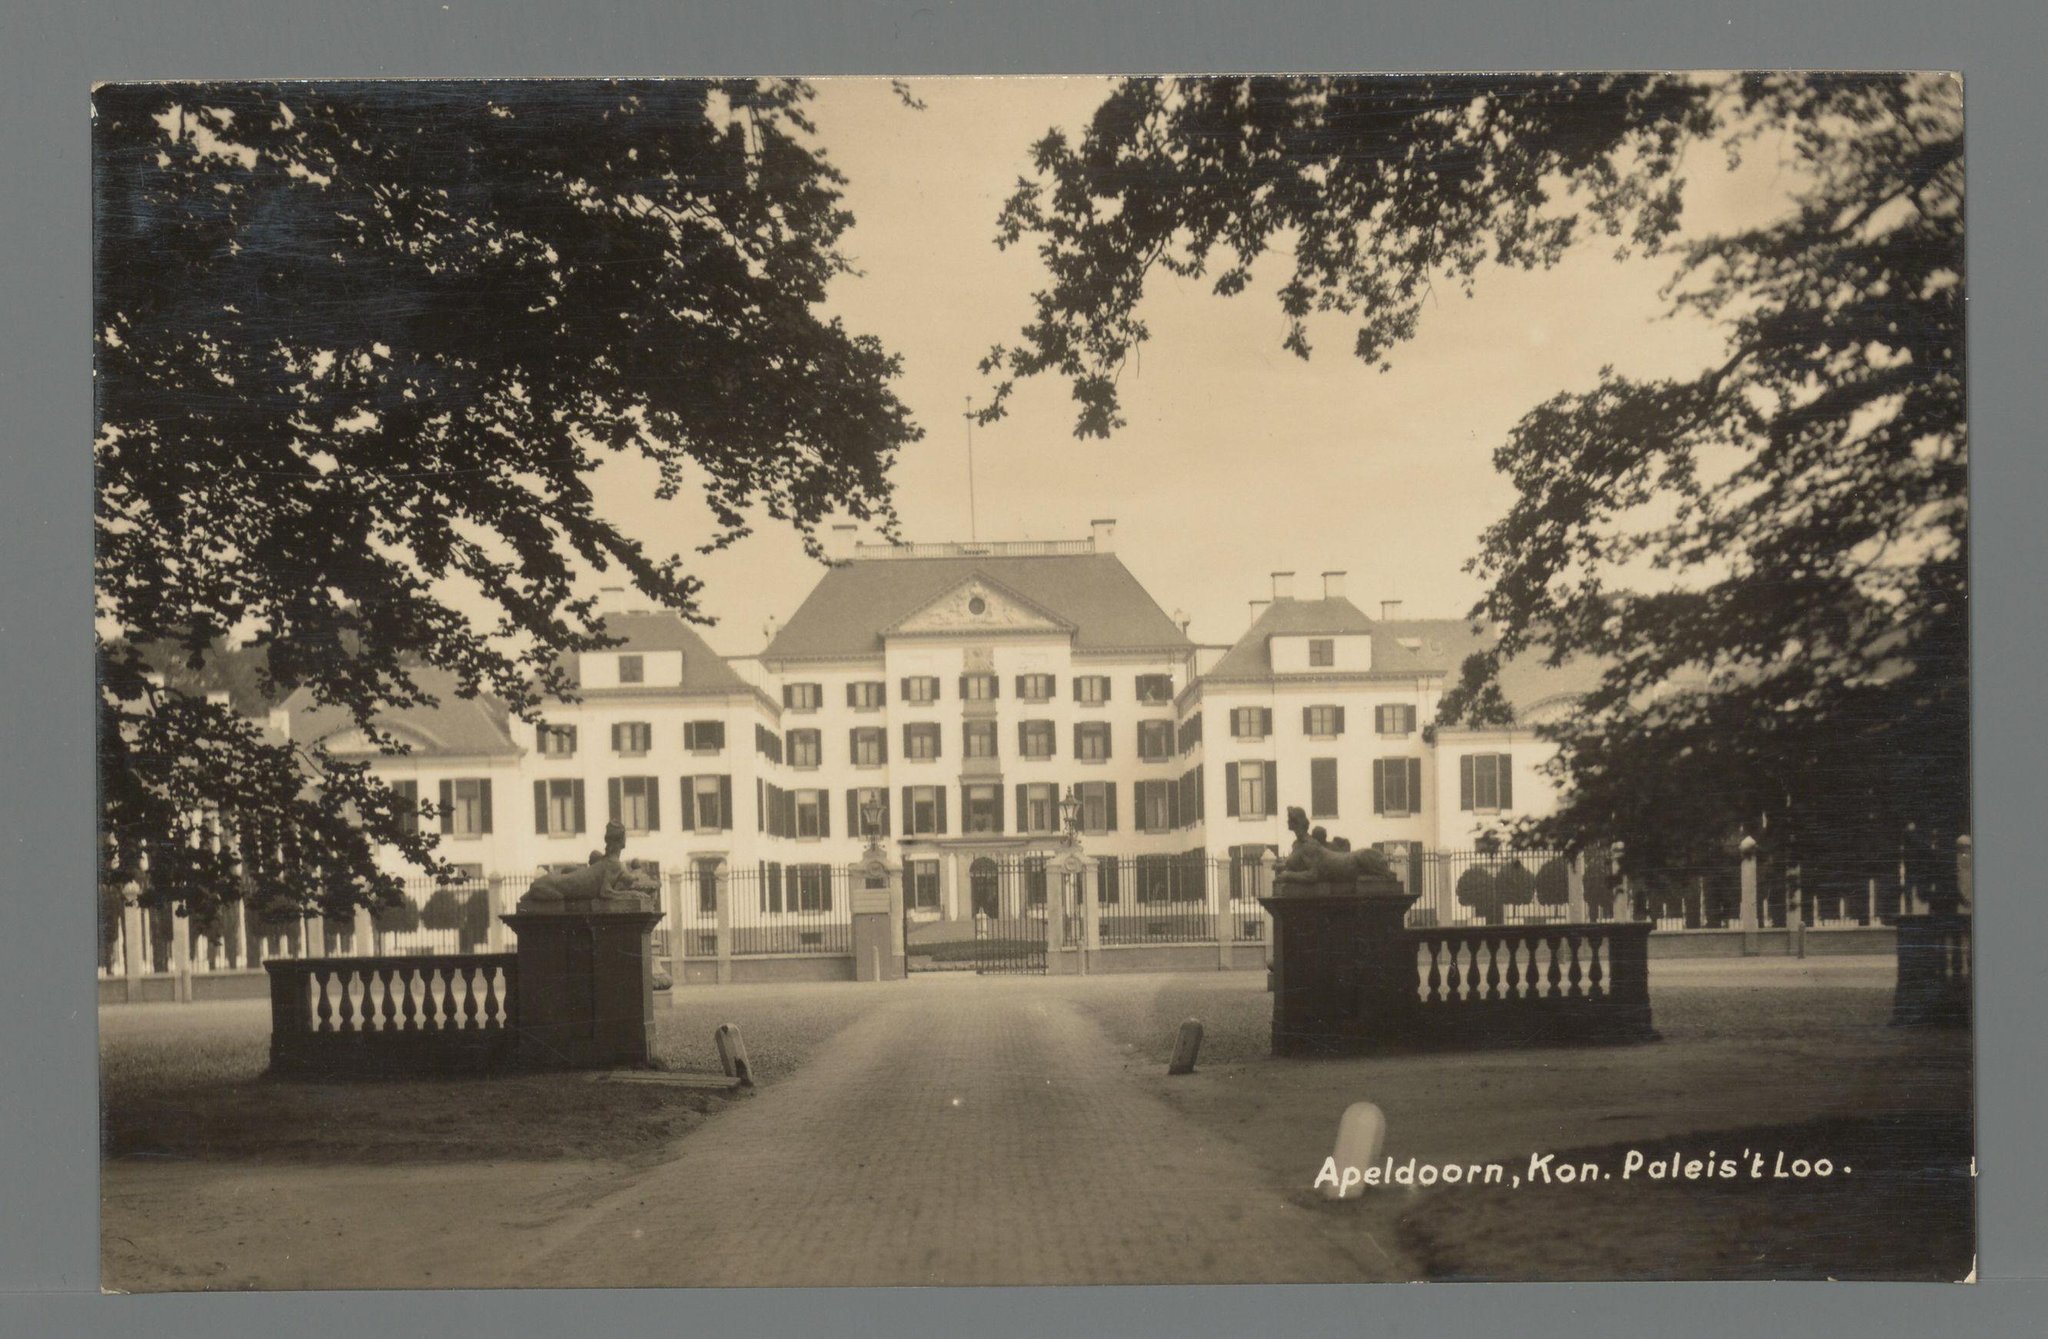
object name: ansichtkaart, prentbriefkaart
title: Apeldoorn, Kon. Paleis 't Loo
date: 1929-1937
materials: paper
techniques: gelatin silver print, writing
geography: arnhem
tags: palace, gate, entrance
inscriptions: postage stamp